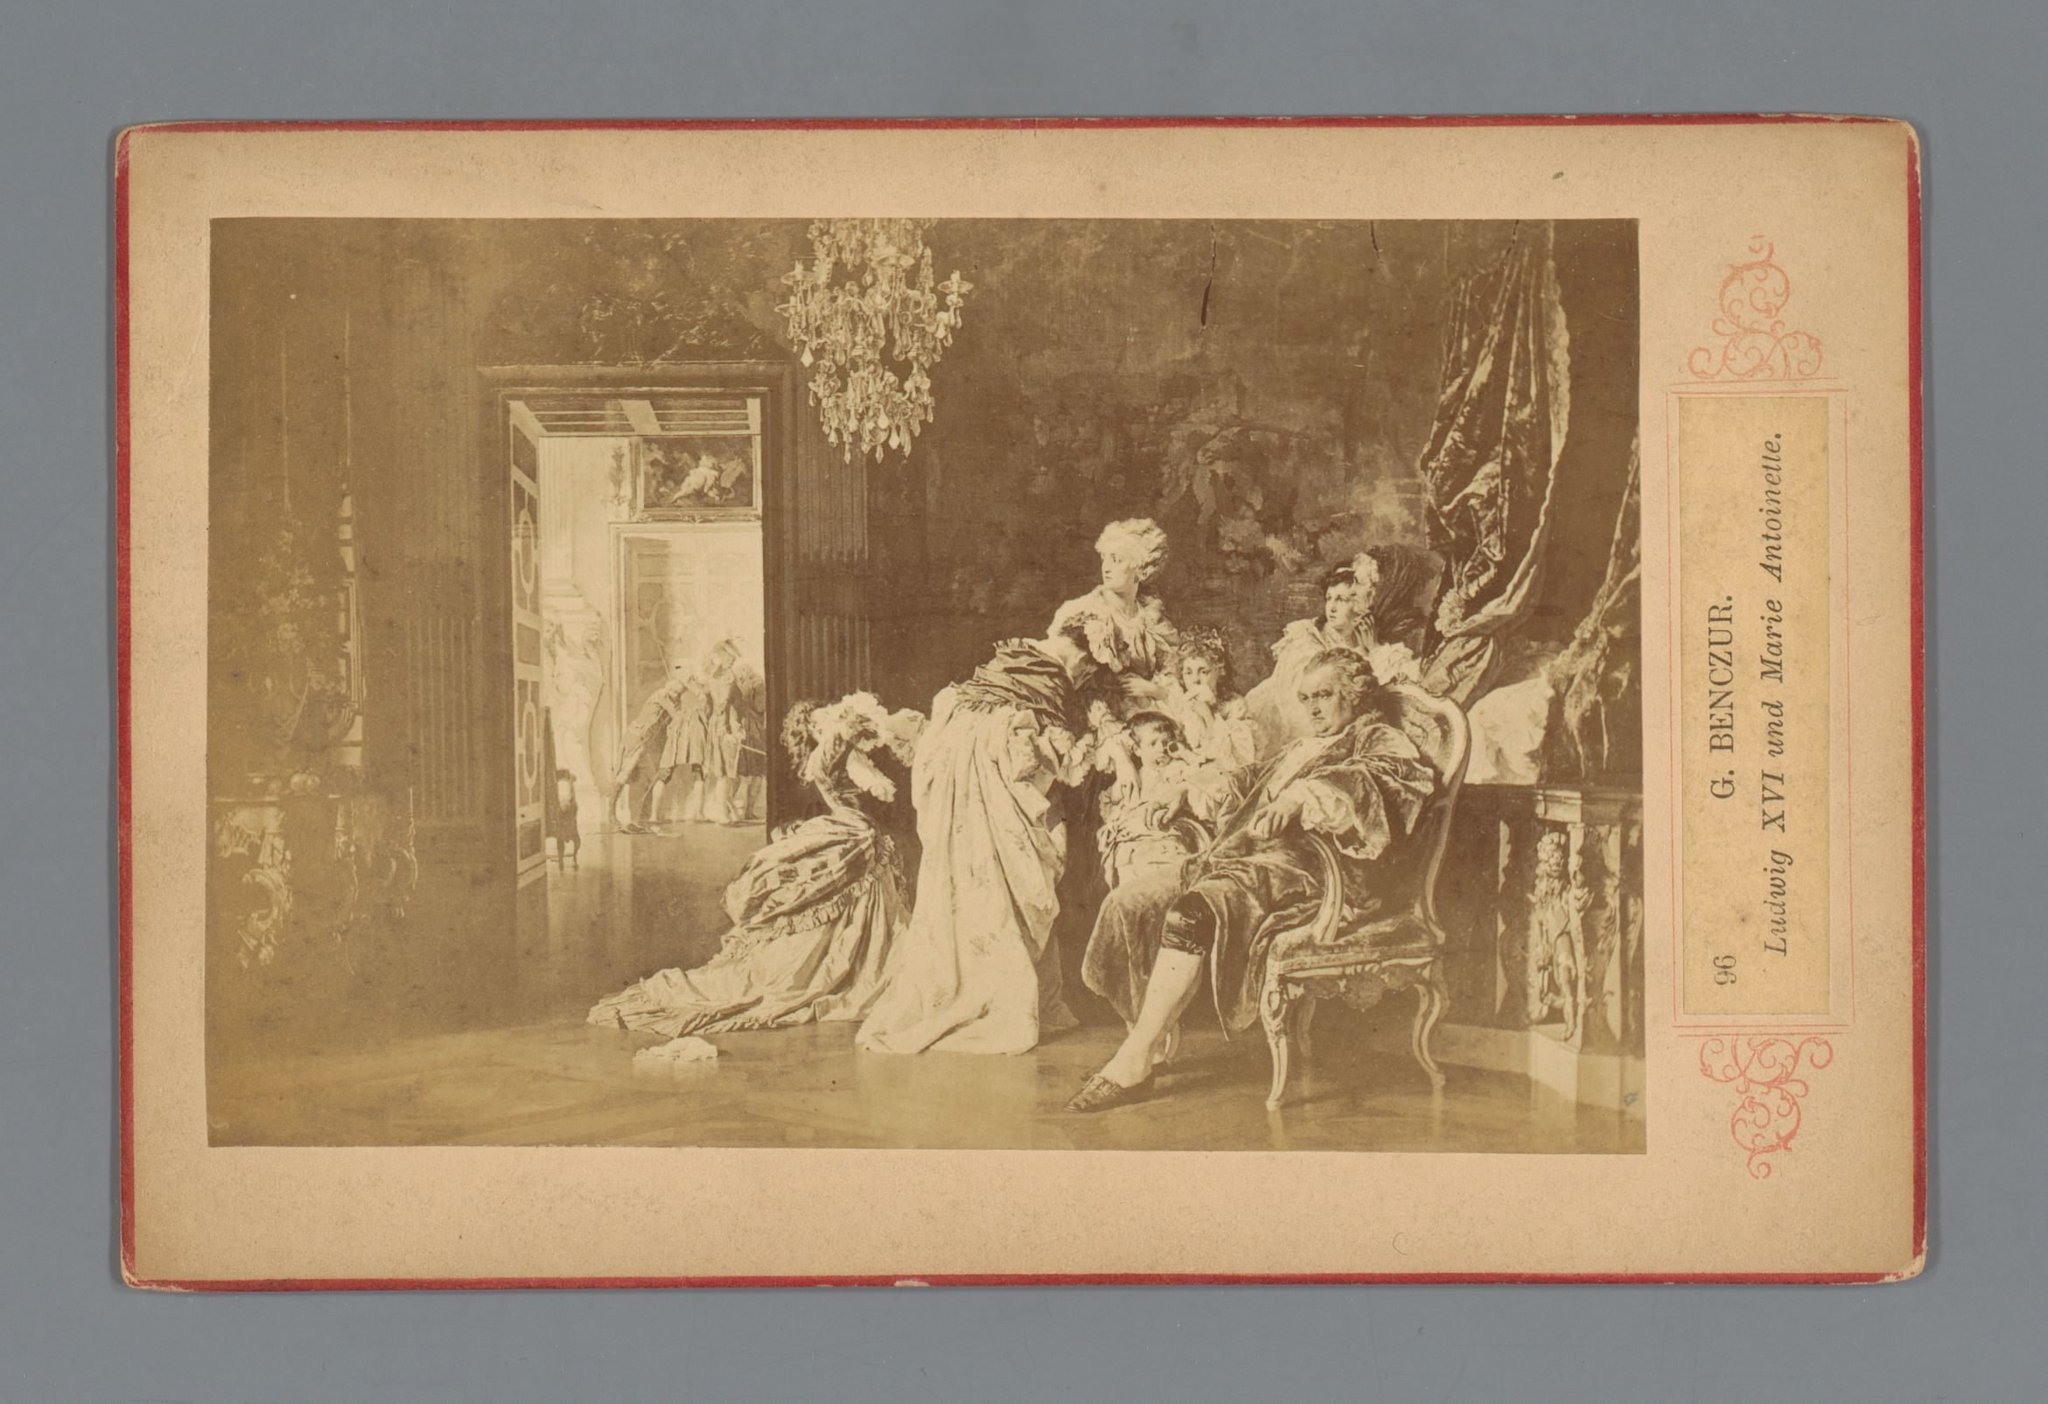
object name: reproduction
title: Ludwig XVI und Marie Antoinette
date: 1875-1890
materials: cardboard, photographic support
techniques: albumen print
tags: lodewijk xvi (koning van frankrijk), vienna, paris, marie antoinette, queen, interior ~ representation of a building, king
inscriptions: number: ‘96’, inscription: ‘[...] Kunsthandelaar Bakkerstraat 70 Arnhem’